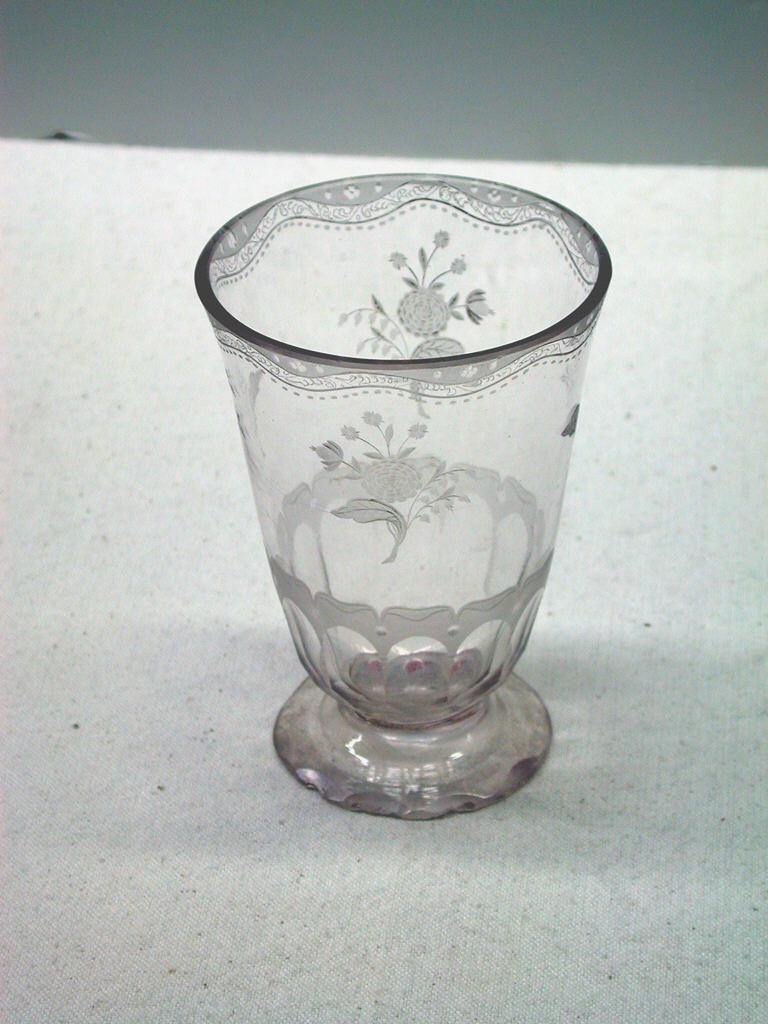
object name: vase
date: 1830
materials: glass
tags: flowers